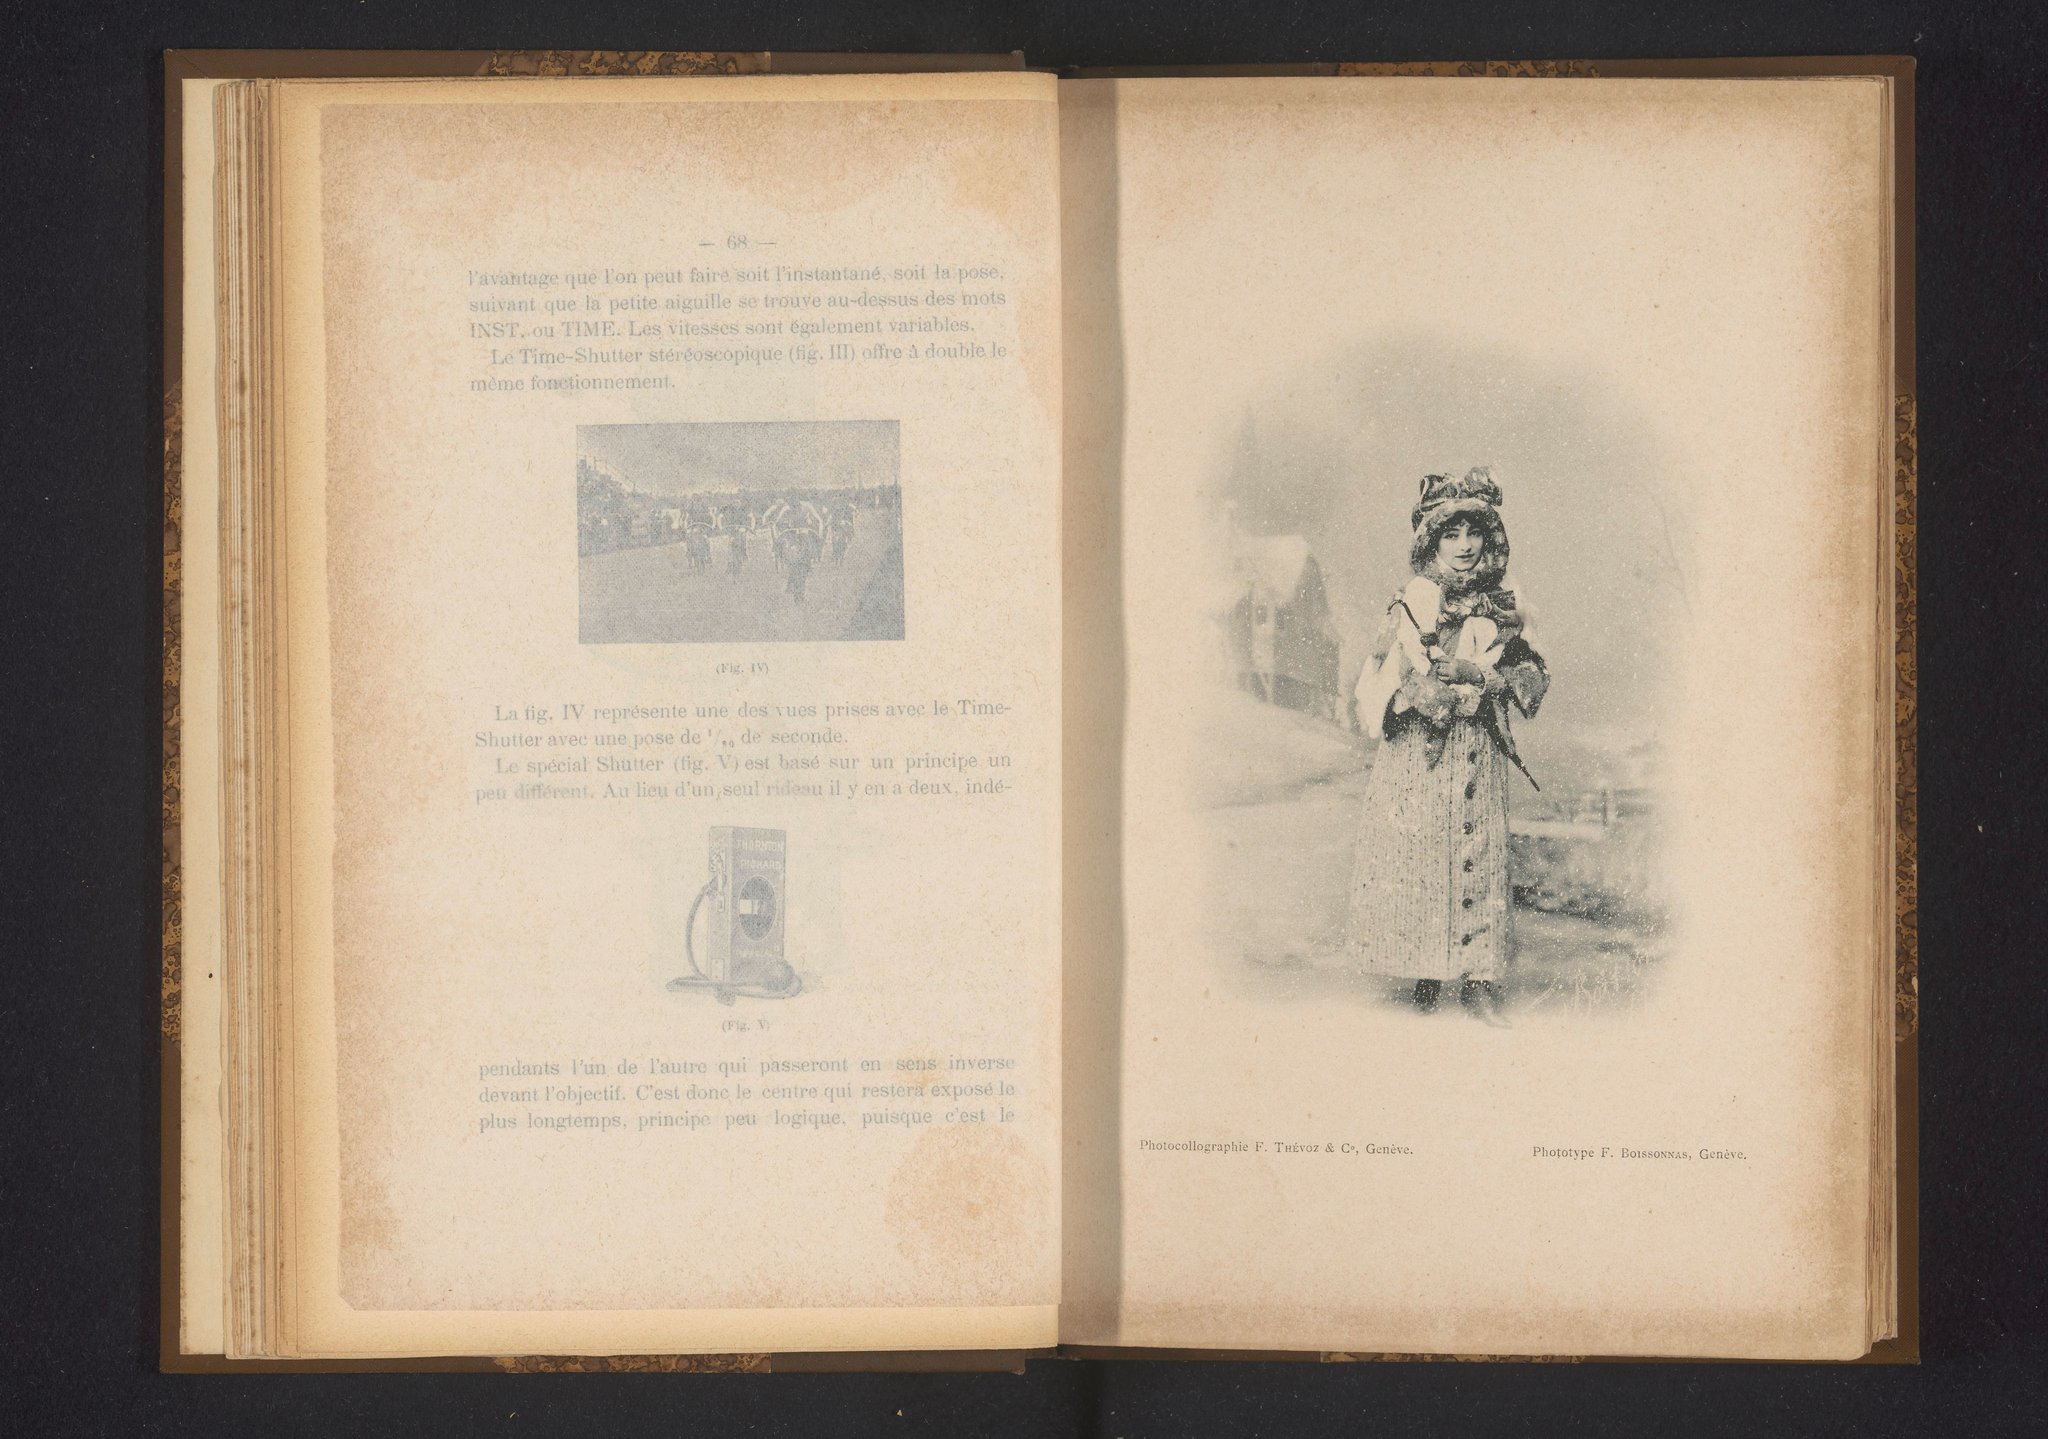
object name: page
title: Portret van een onbekende jonge vrouw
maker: frédéric boissonnas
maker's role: fotograaf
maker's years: 1858-1946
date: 1888-1893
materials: paper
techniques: photograph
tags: adolescent, young woman, maiden